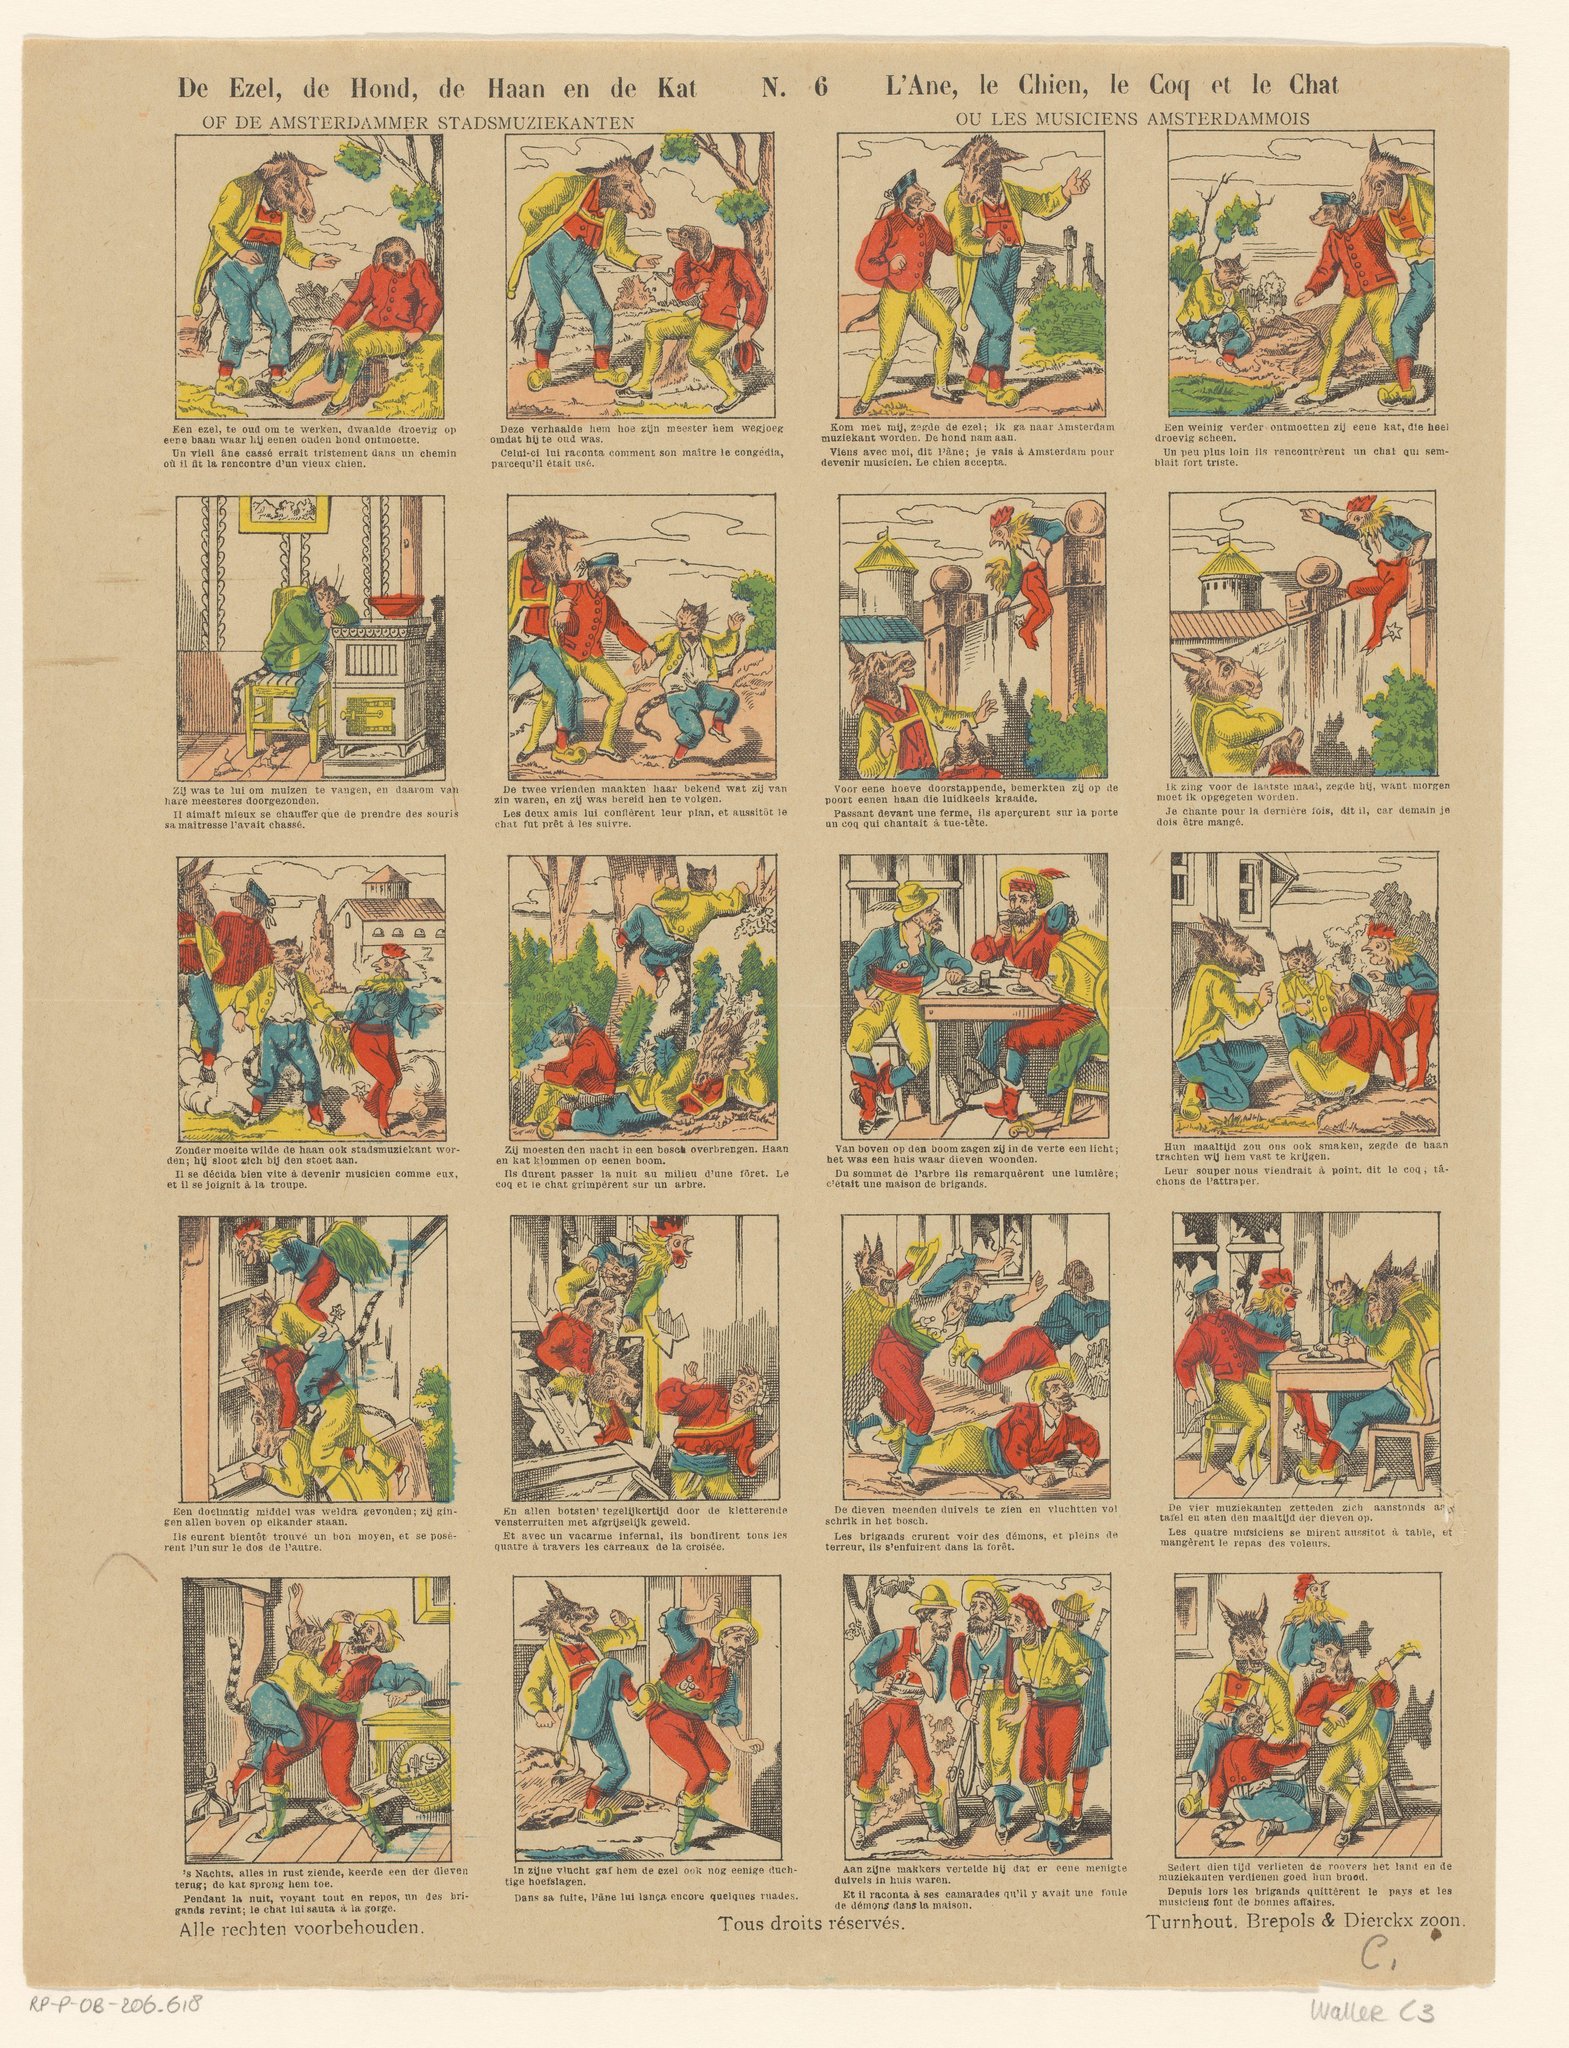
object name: print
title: De ezel, de hond, de haan en de kat / Of de Amsterdammer stadsmuziekanten / L'ane, le chien, le coq et le chat / Ou les musiciens Amsterdammois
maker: Anonymous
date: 1833-1911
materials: paper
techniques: lithograph, letterpress printing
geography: turnhout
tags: cat, ass, donkey, fowl (cock, hen, chicken, etc.), tales and fairy tales, dog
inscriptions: octrooivermelding, gedrukt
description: Blad met 20 voorstellingen uit het sprookje van de ezel, de hond, de haan en de kat: de Amsterdammer stadsmuzikanten. Onder elke afbeelding een onderschrift in het Nederlands en in het Frans. Genummerd midden boven: N. 6.